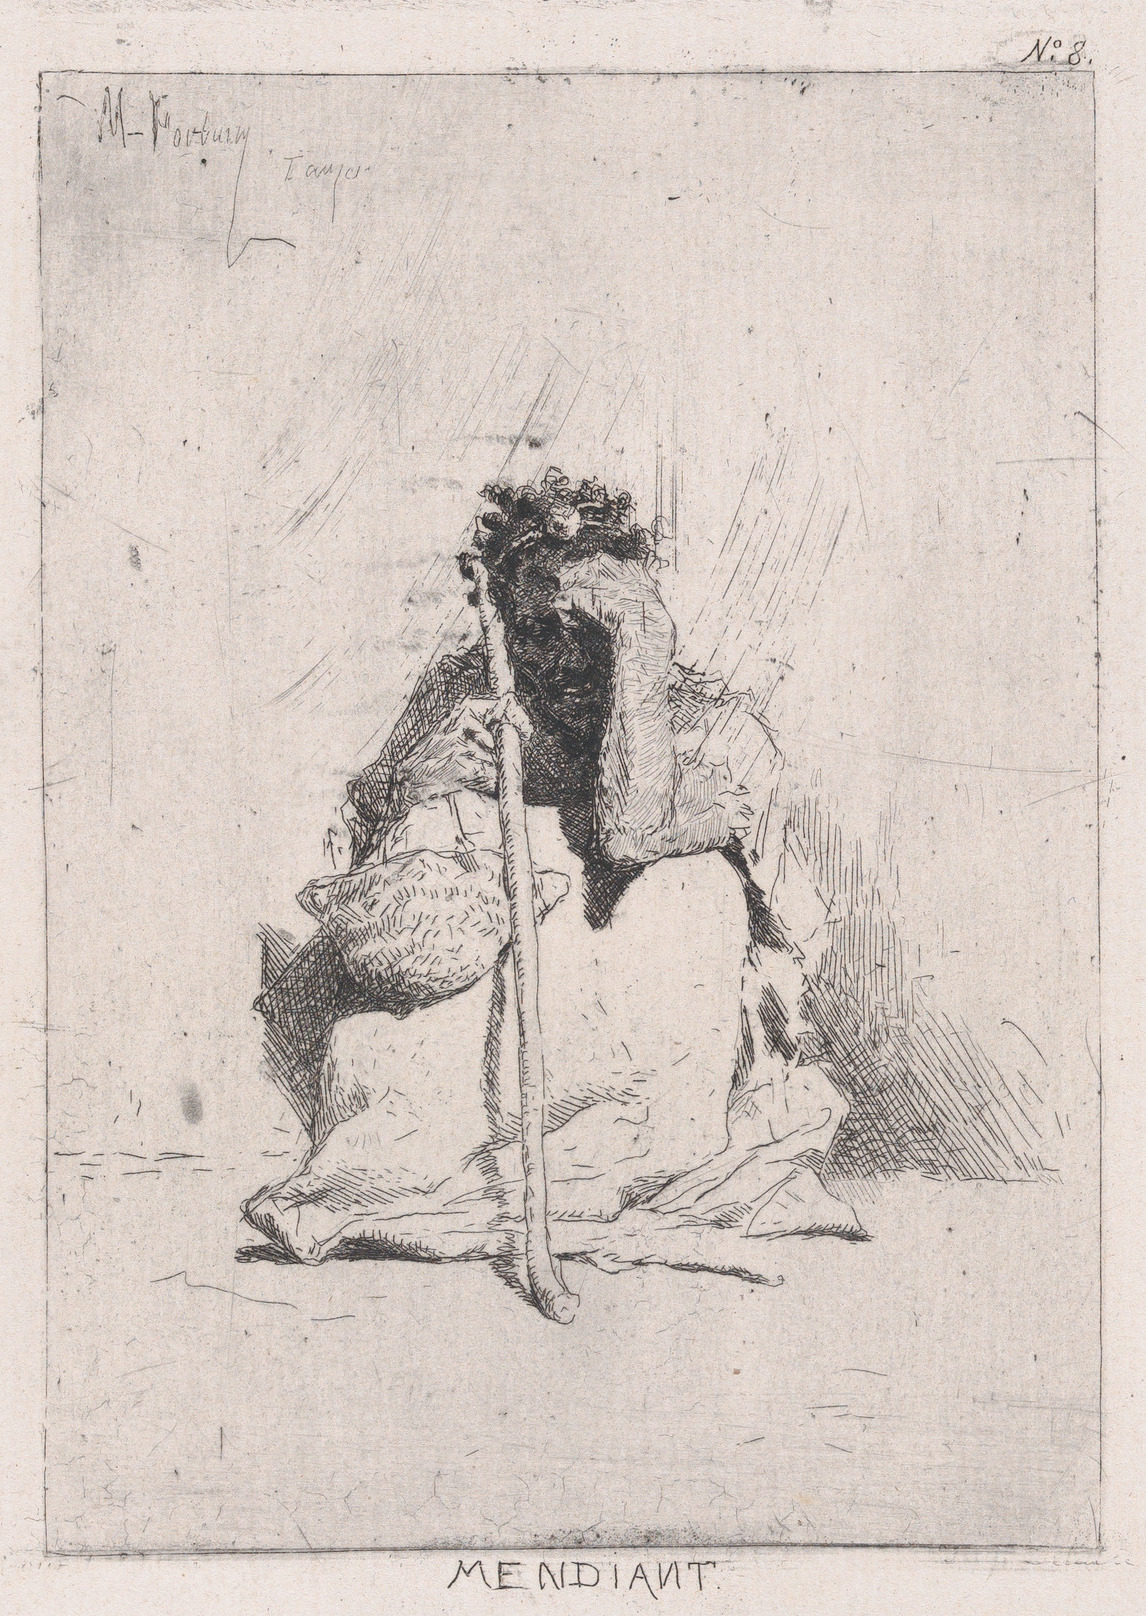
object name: print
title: A beggar, seated on the ground holding a stick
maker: mariano fortuny, 1838–1874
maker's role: artist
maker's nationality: spanish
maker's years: 1838-1874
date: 1862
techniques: etching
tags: human figures